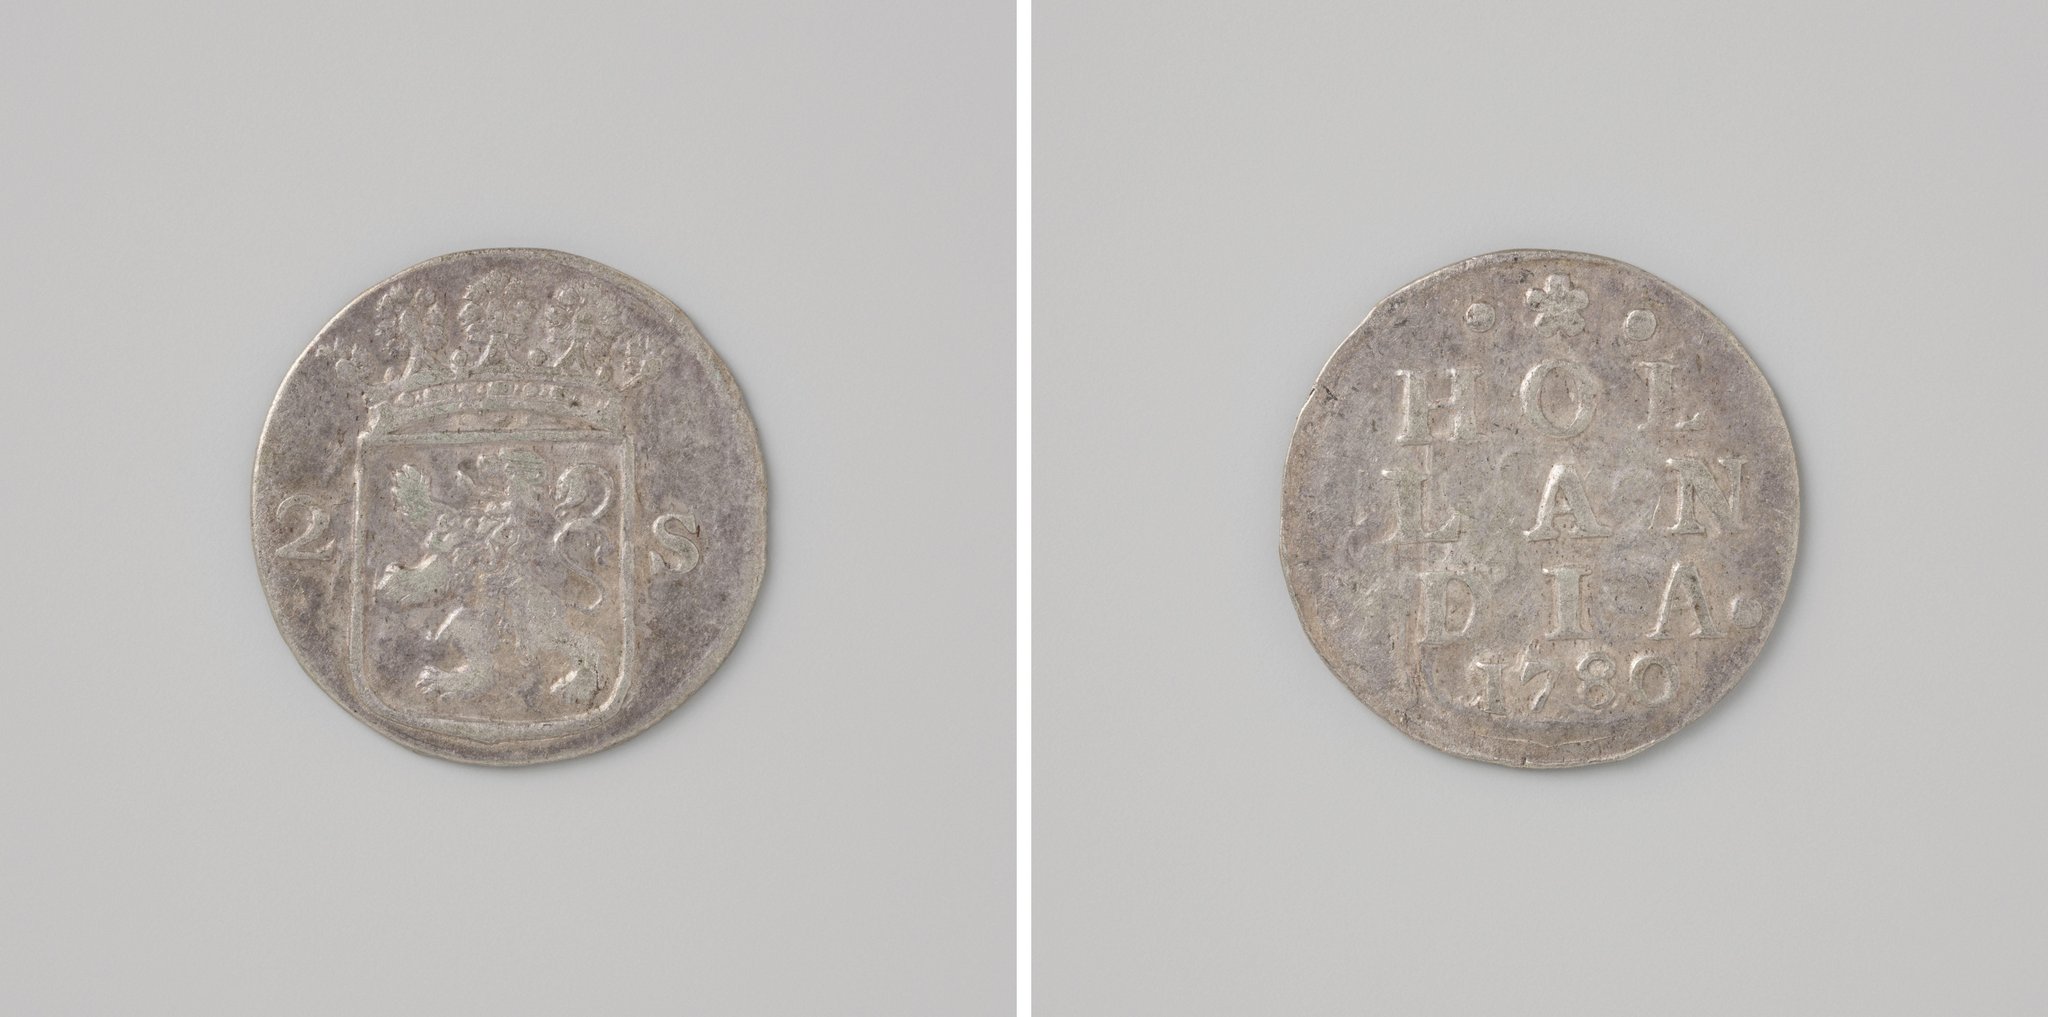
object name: coin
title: 2 Stuiver, dubbeltje: 18e-eeuwse zilveren dubbele stuiver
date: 1780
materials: cardboard, plastic, silver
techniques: striking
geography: netherlands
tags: netherlands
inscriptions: inscription: ‘HOL / LAN / DIA / 1780’, inscription: ‘2 S’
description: Een achtiende eeuwse zilveren dubbele stuiver, aangeboden ter gelegenheid van de verschijning van de Algemene Geschiedenis der Nederlanden. Voorzijde: een gekroond wapen met een leeuw erin. Links ervan staat een 2 en rechts ervan staat de letter S. Keerzijde: sterretje met opschrift eronder. De stuiver zit tussen twee laagjes plastic vastgemaakt tussen twee stukjes karton, waarop uitleg en toelichting bij de munt.